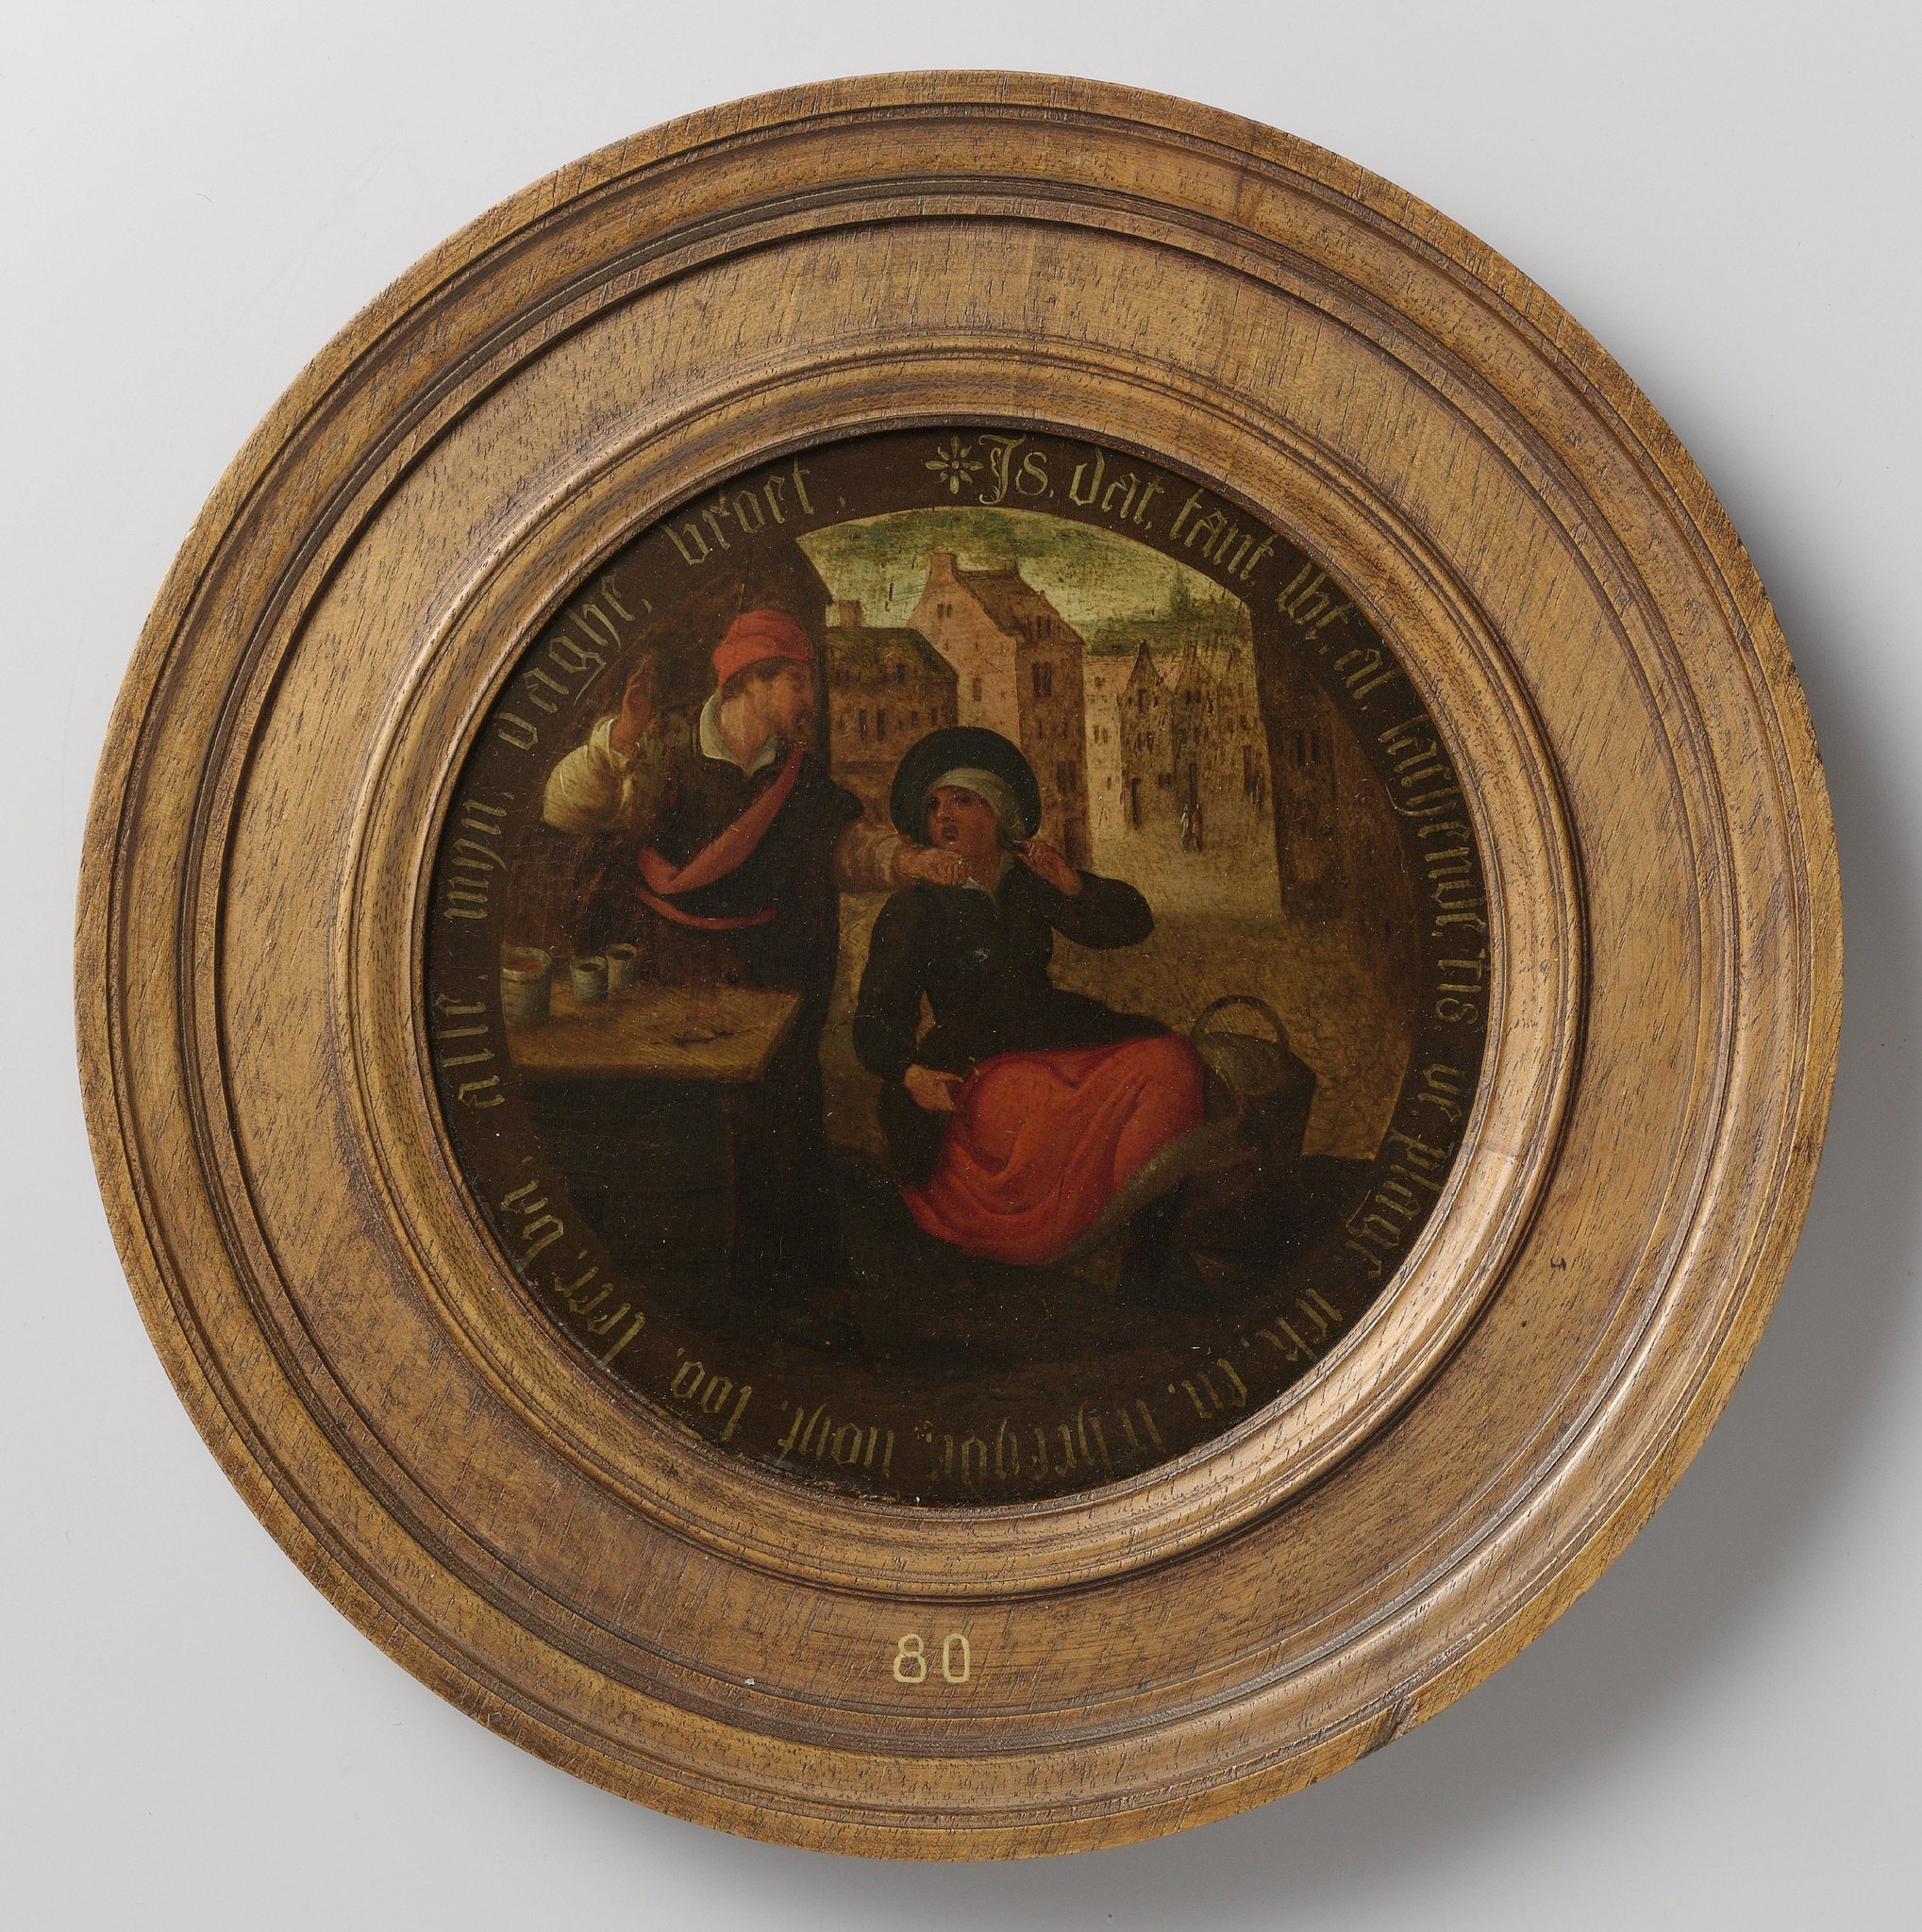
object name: plate dish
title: Tooth Extractor (Tooth Puller)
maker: Anonymous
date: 1580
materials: oil, panel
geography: southern netherlands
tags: (barber as) dentist, quack extracting teeth or molars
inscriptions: inscription: ‘Is dat tant wt al lachende tis de plage ick en schreyde noyt soo seer van alle mijn daghe vroet’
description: De tandentrekker. Een vrouw zit bij het stalletje van een tandentrekker op een stadsplein. Om de ronde voorstelling loopt een vers. Zie ook nrs. SK-A-4465 en SK-A-4467.